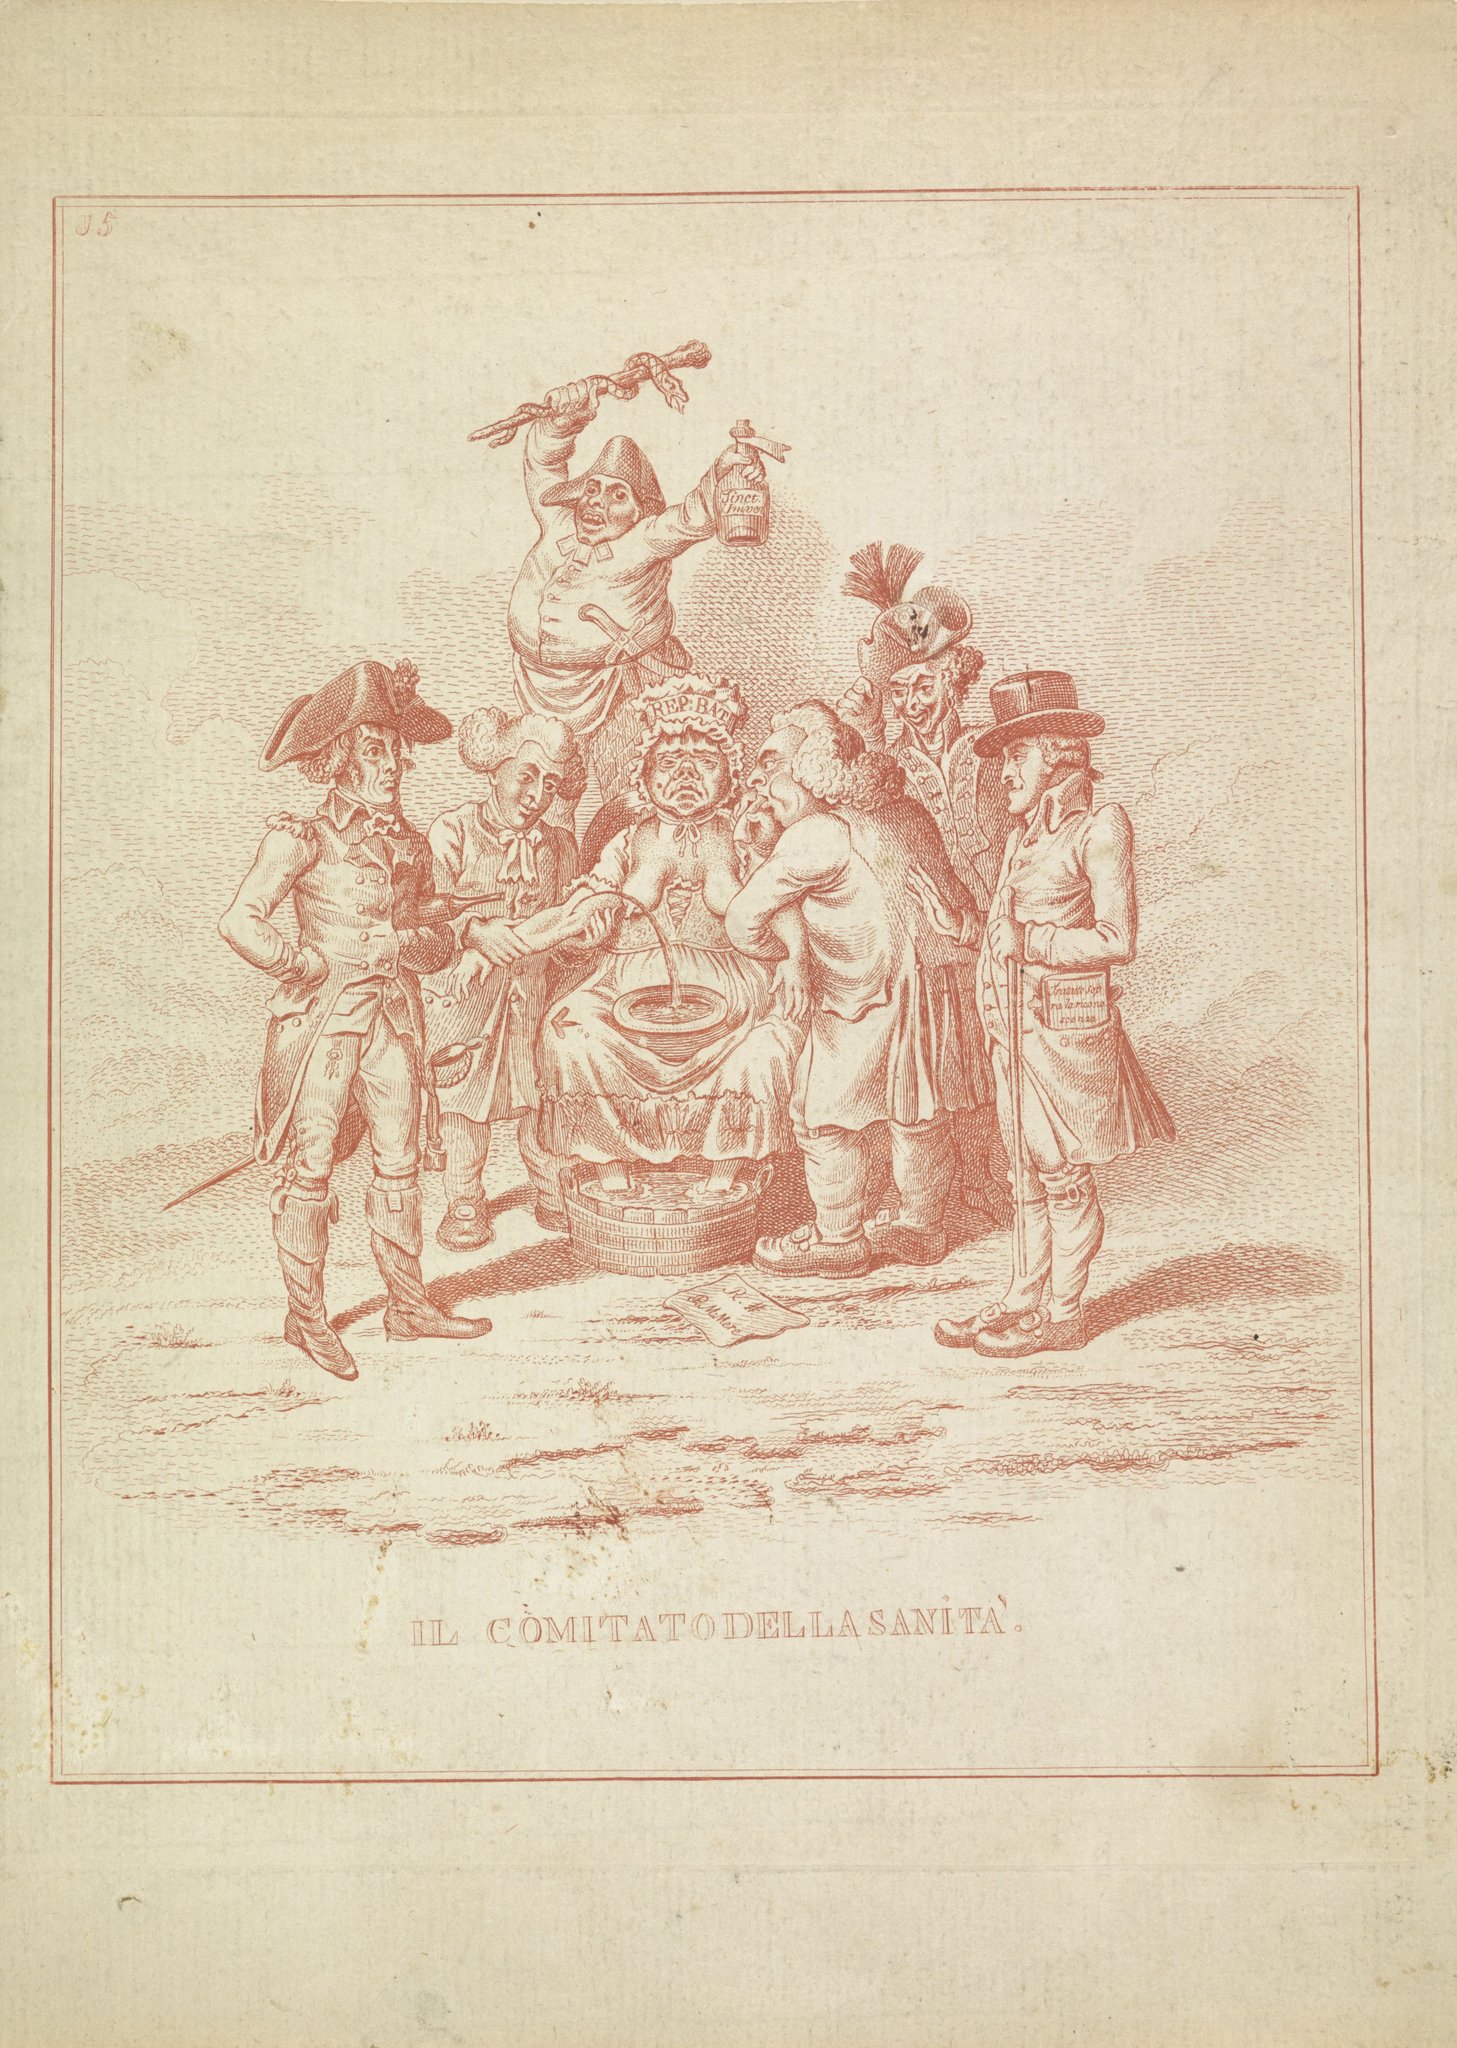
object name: print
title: Il Comitato della Sanita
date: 1799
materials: paper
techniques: engraving, etching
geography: venice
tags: bleeding, blood-letting, e.g.: with the aid of cupping-glasses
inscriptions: collector's mark: Lugt 2228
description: Spotprent op het (niet bestaande) Comité van Gezondheid, 1795. Een groep van Nederlandse en Franse kwakzalvers rondom de Nederlandse Maagd van de Bataafse Republiek, voorgesteld als een oude lelijke vrouw met ontblote borsten. Een van de charlatans heeft haar ader geopend en bloed spuit in een schotel in haar schoot. De staande burger rechts is waarschijnlijk de chirurgijn Willem Leurs die een verhandeling schreef over aderlaten.